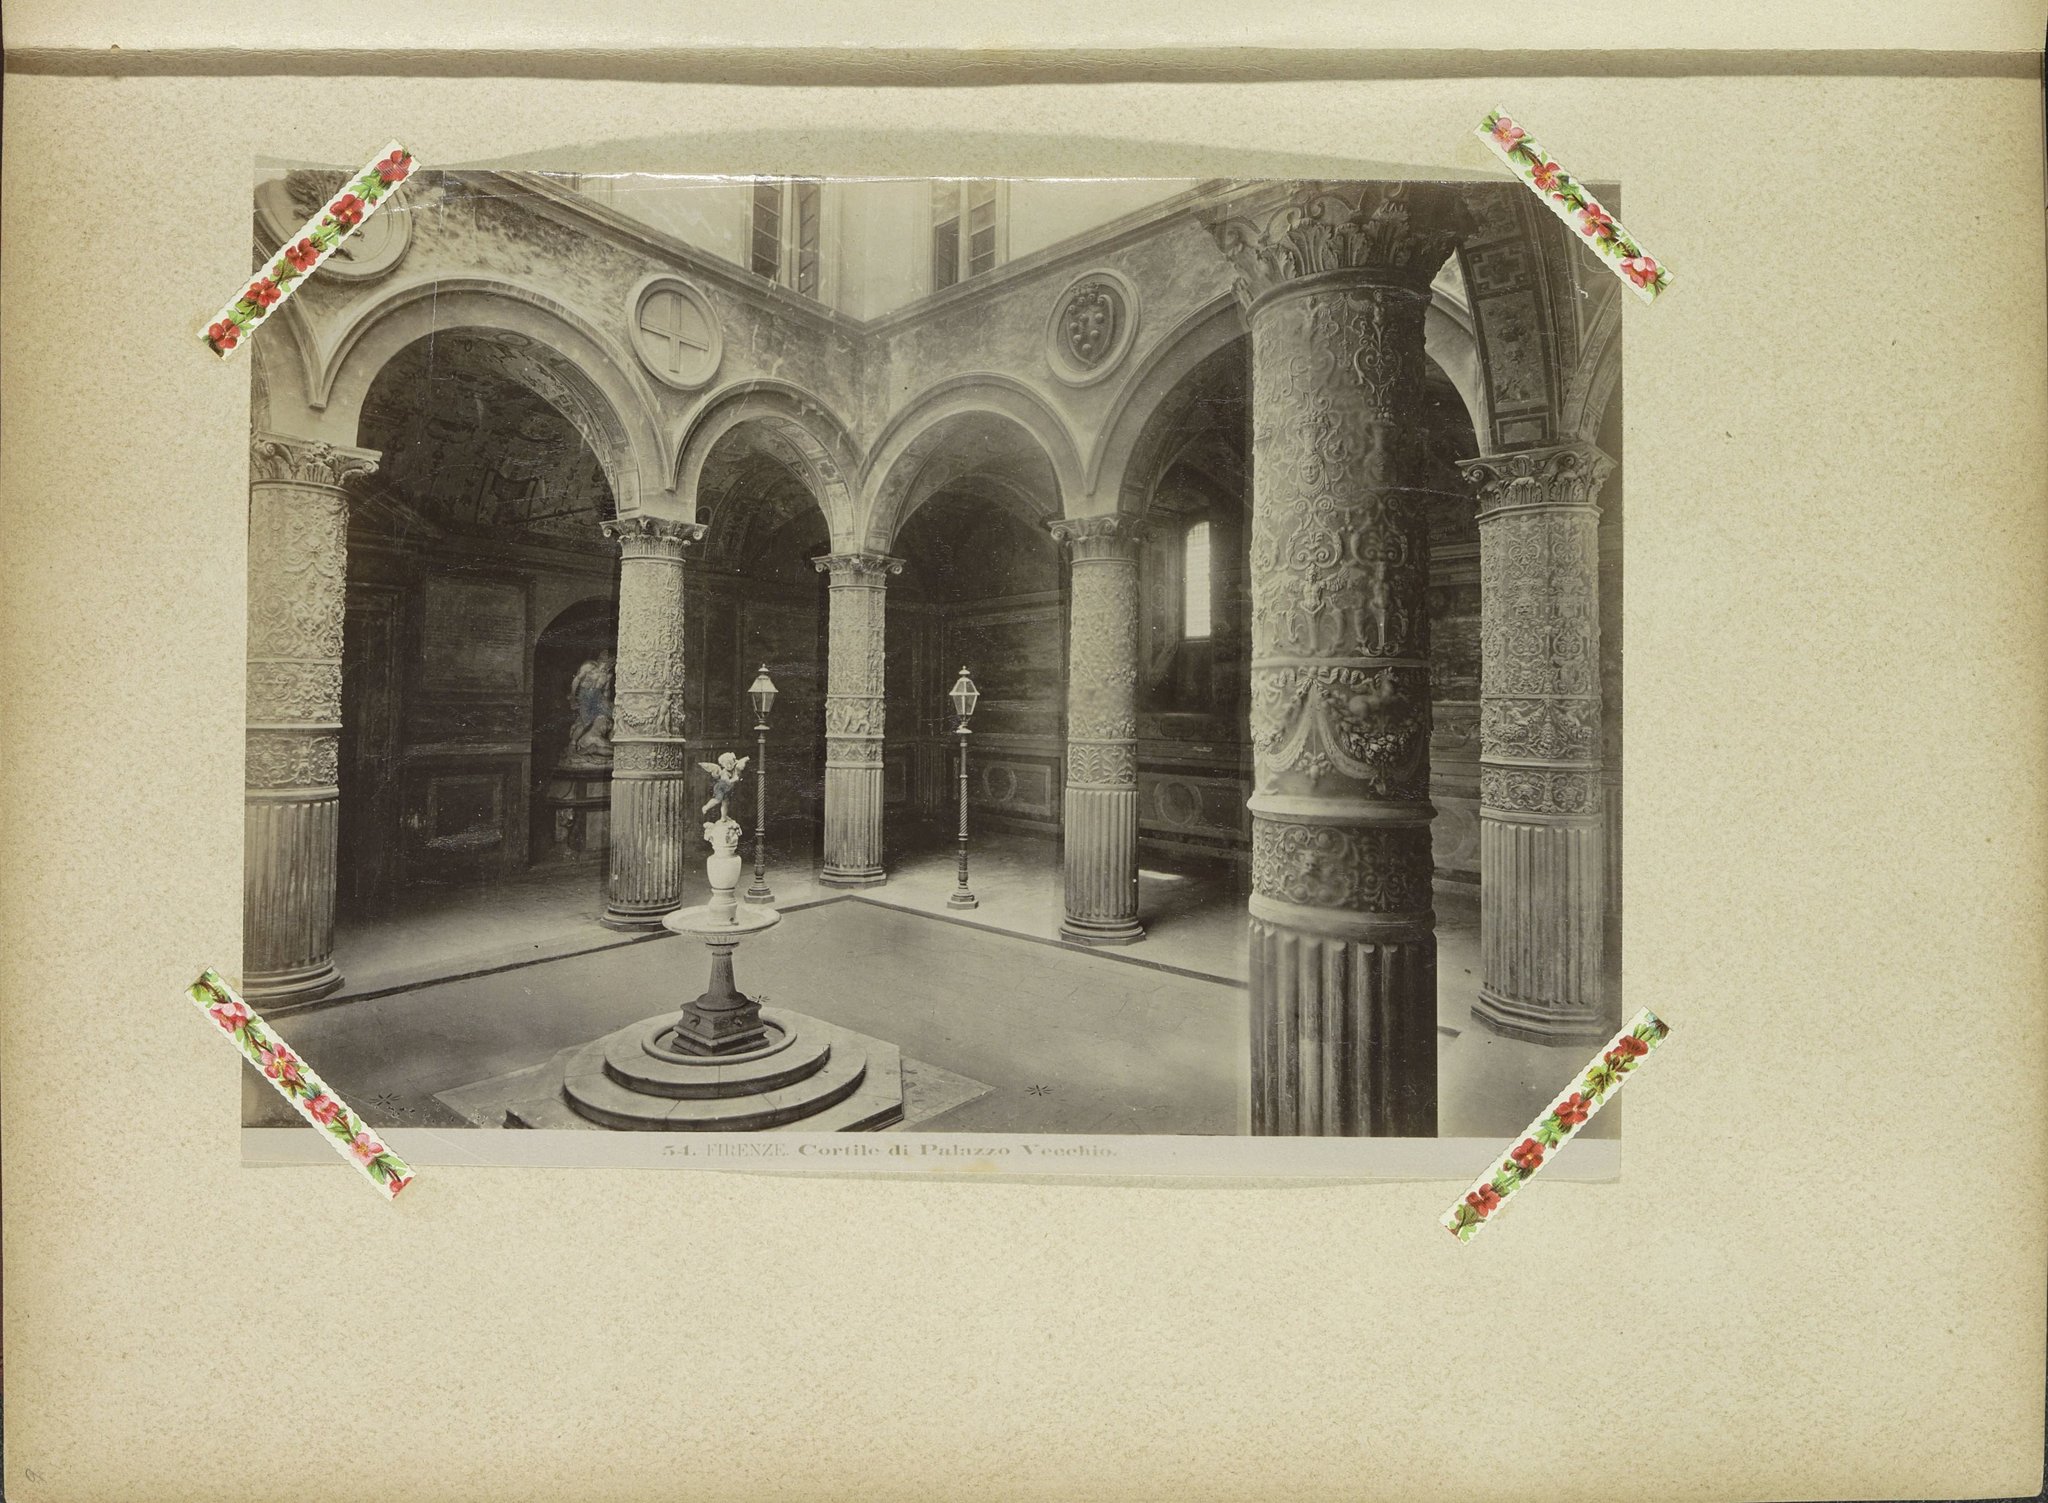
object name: photograph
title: Binnenplaats van het Palazzo Vecchio in Florence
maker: Anonymous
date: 1860-1900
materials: photographic support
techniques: albumen print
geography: palazzo vecchio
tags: piece of sculpture, reproduction of a piece of sculpture, courtyard, sculpture (+ relief ~ sculpture)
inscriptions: number: ‘54’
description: Onderdeel van Fotoalbum met opnames van bezienswaardigheden in Italiaanse steden en van kunstwerken.